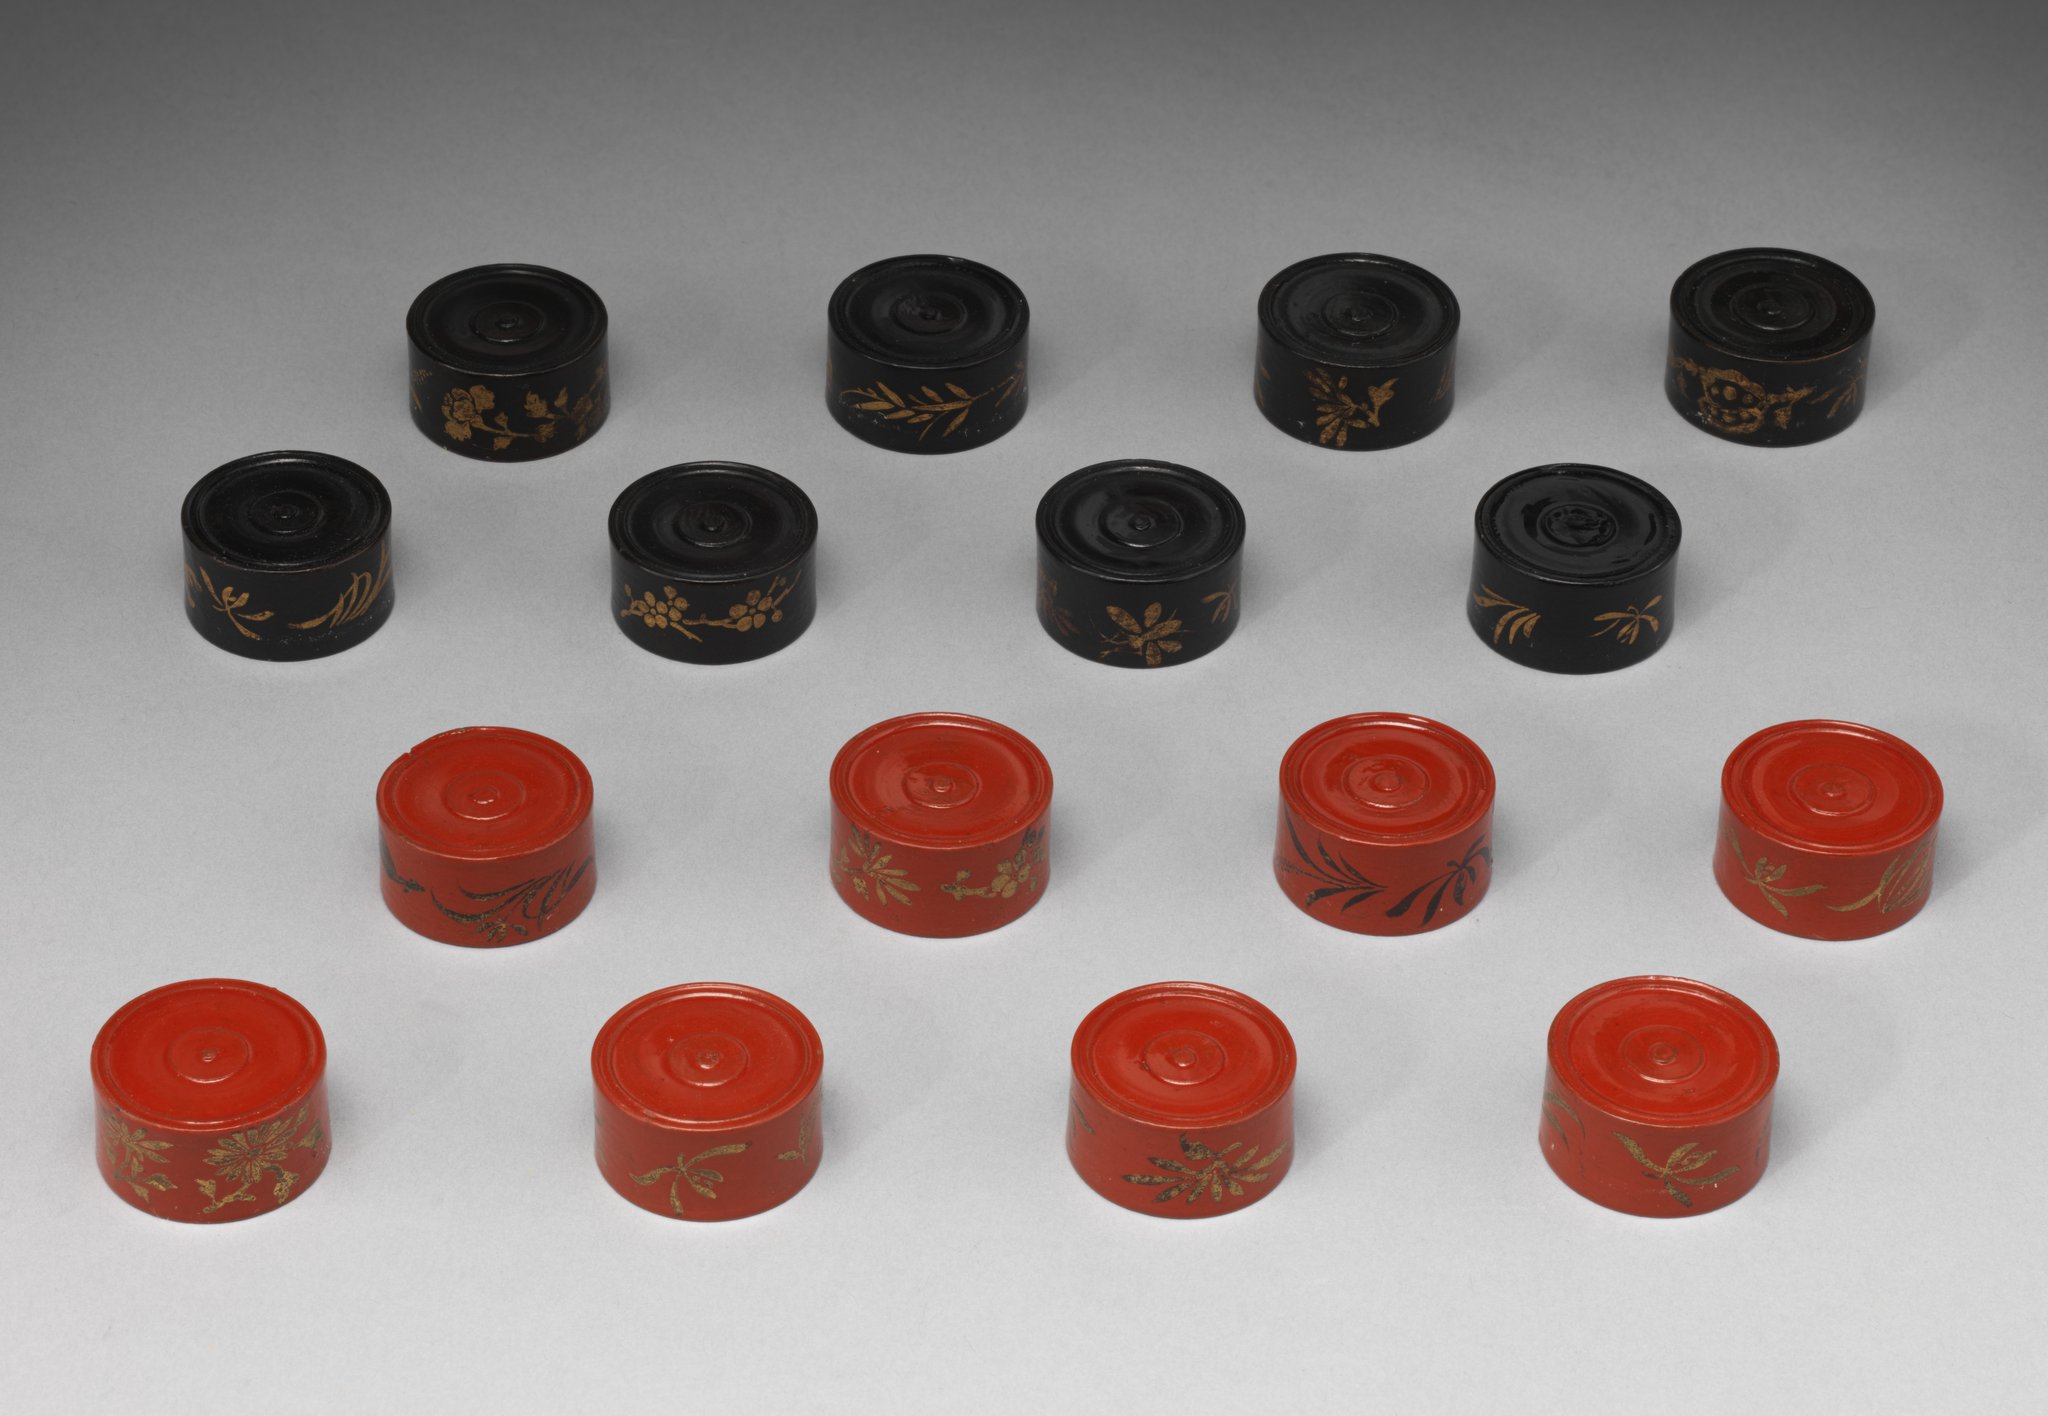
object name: draughtsman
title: Draughtsmen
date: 1701-1800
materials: wood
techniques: lacquer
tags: games